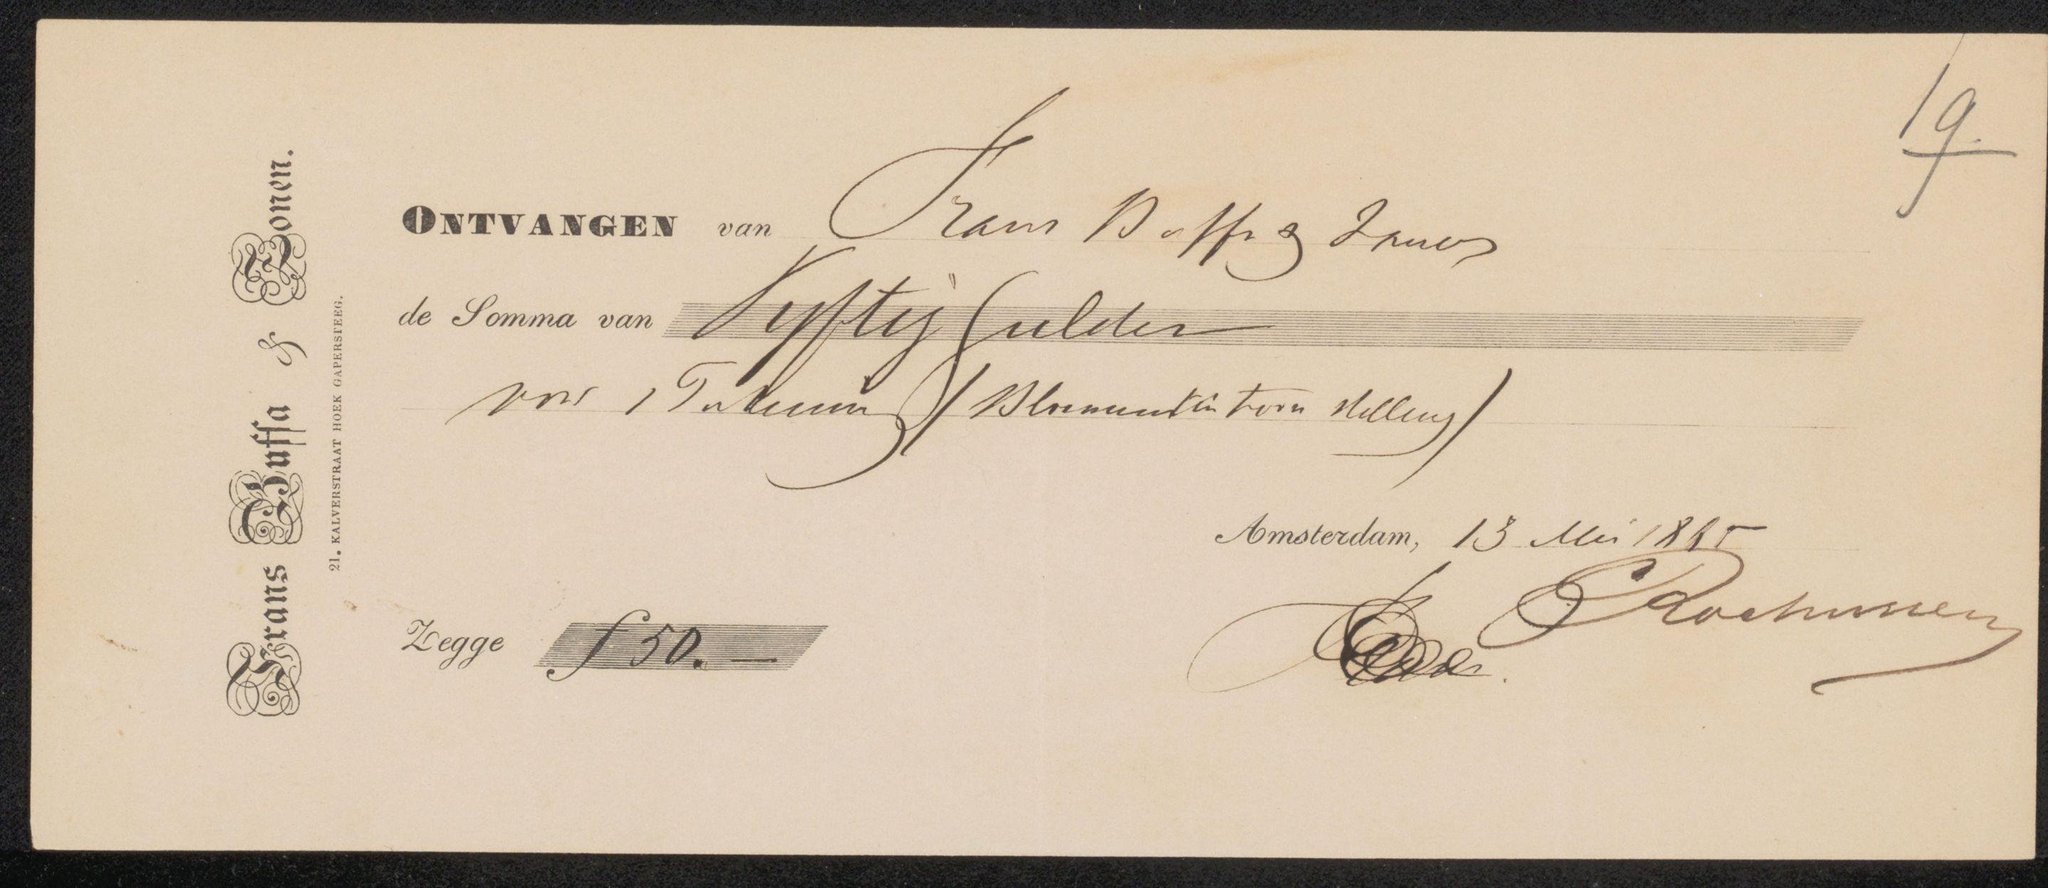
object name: ontvangstbewijs, kwitantie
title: Kwitantie voor Charles Rochussen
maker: charles rochussen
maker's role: draughtsman, painter, print maker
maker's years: 1814-1894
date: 1865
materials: ink, paper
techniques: pen, printing, writing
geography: amsterdam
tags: drawing, exhibition ~ art, money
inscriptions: collector's mark: Lugt 2233